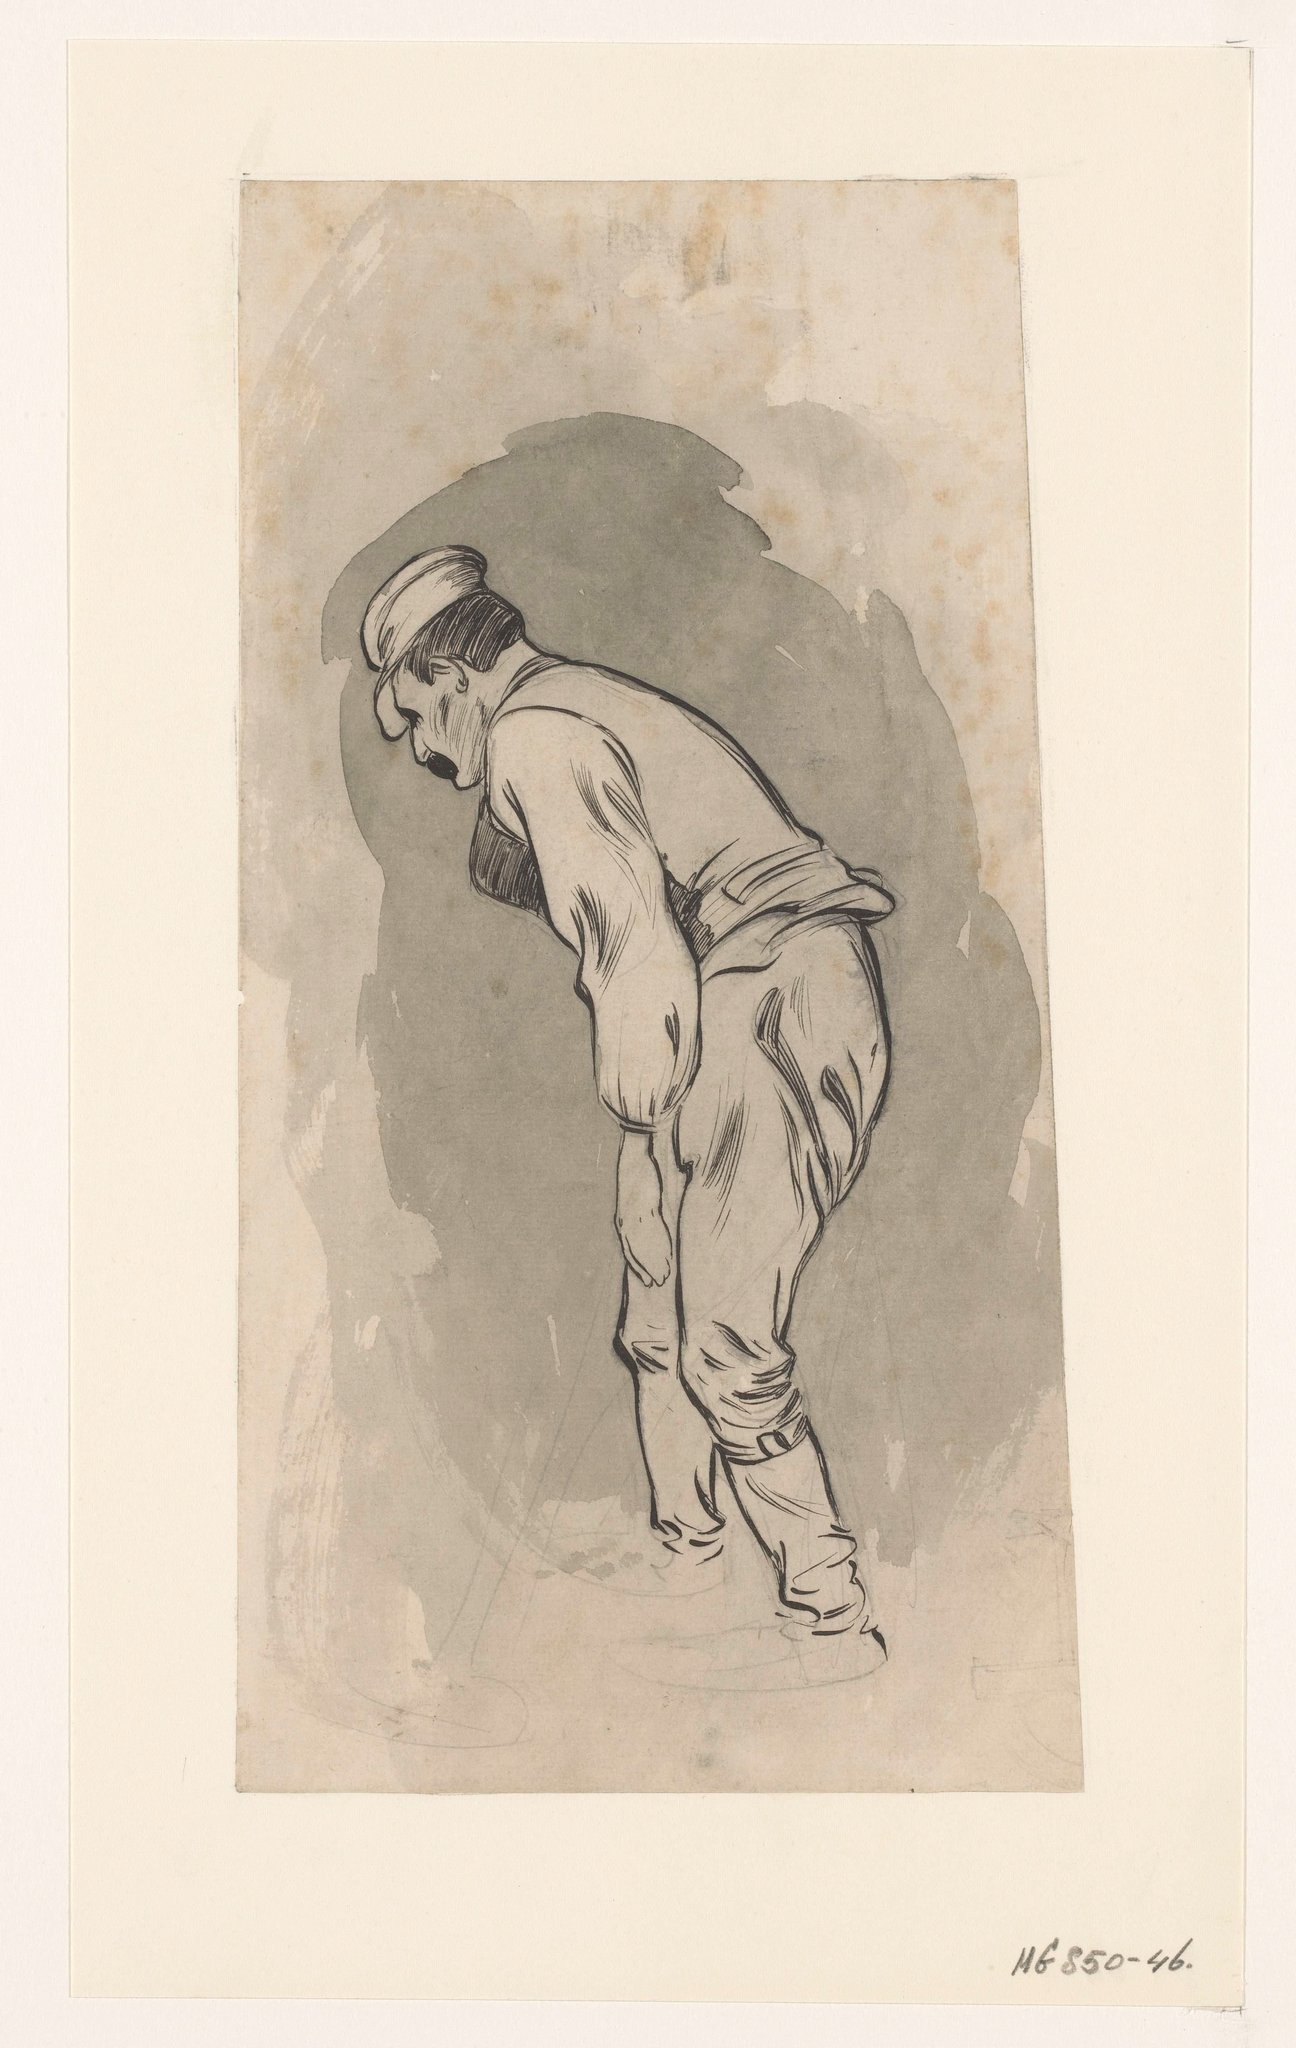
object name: drawing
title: Arbeider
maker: jan de waardt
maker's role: draughtsman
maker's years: 1871-1909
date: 1881-1899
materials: ink, paper, pencil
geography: netherlands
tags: working class, labourers, netherlands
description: Studie van een arbeider, naar links voorovergebogen met pet en snor.